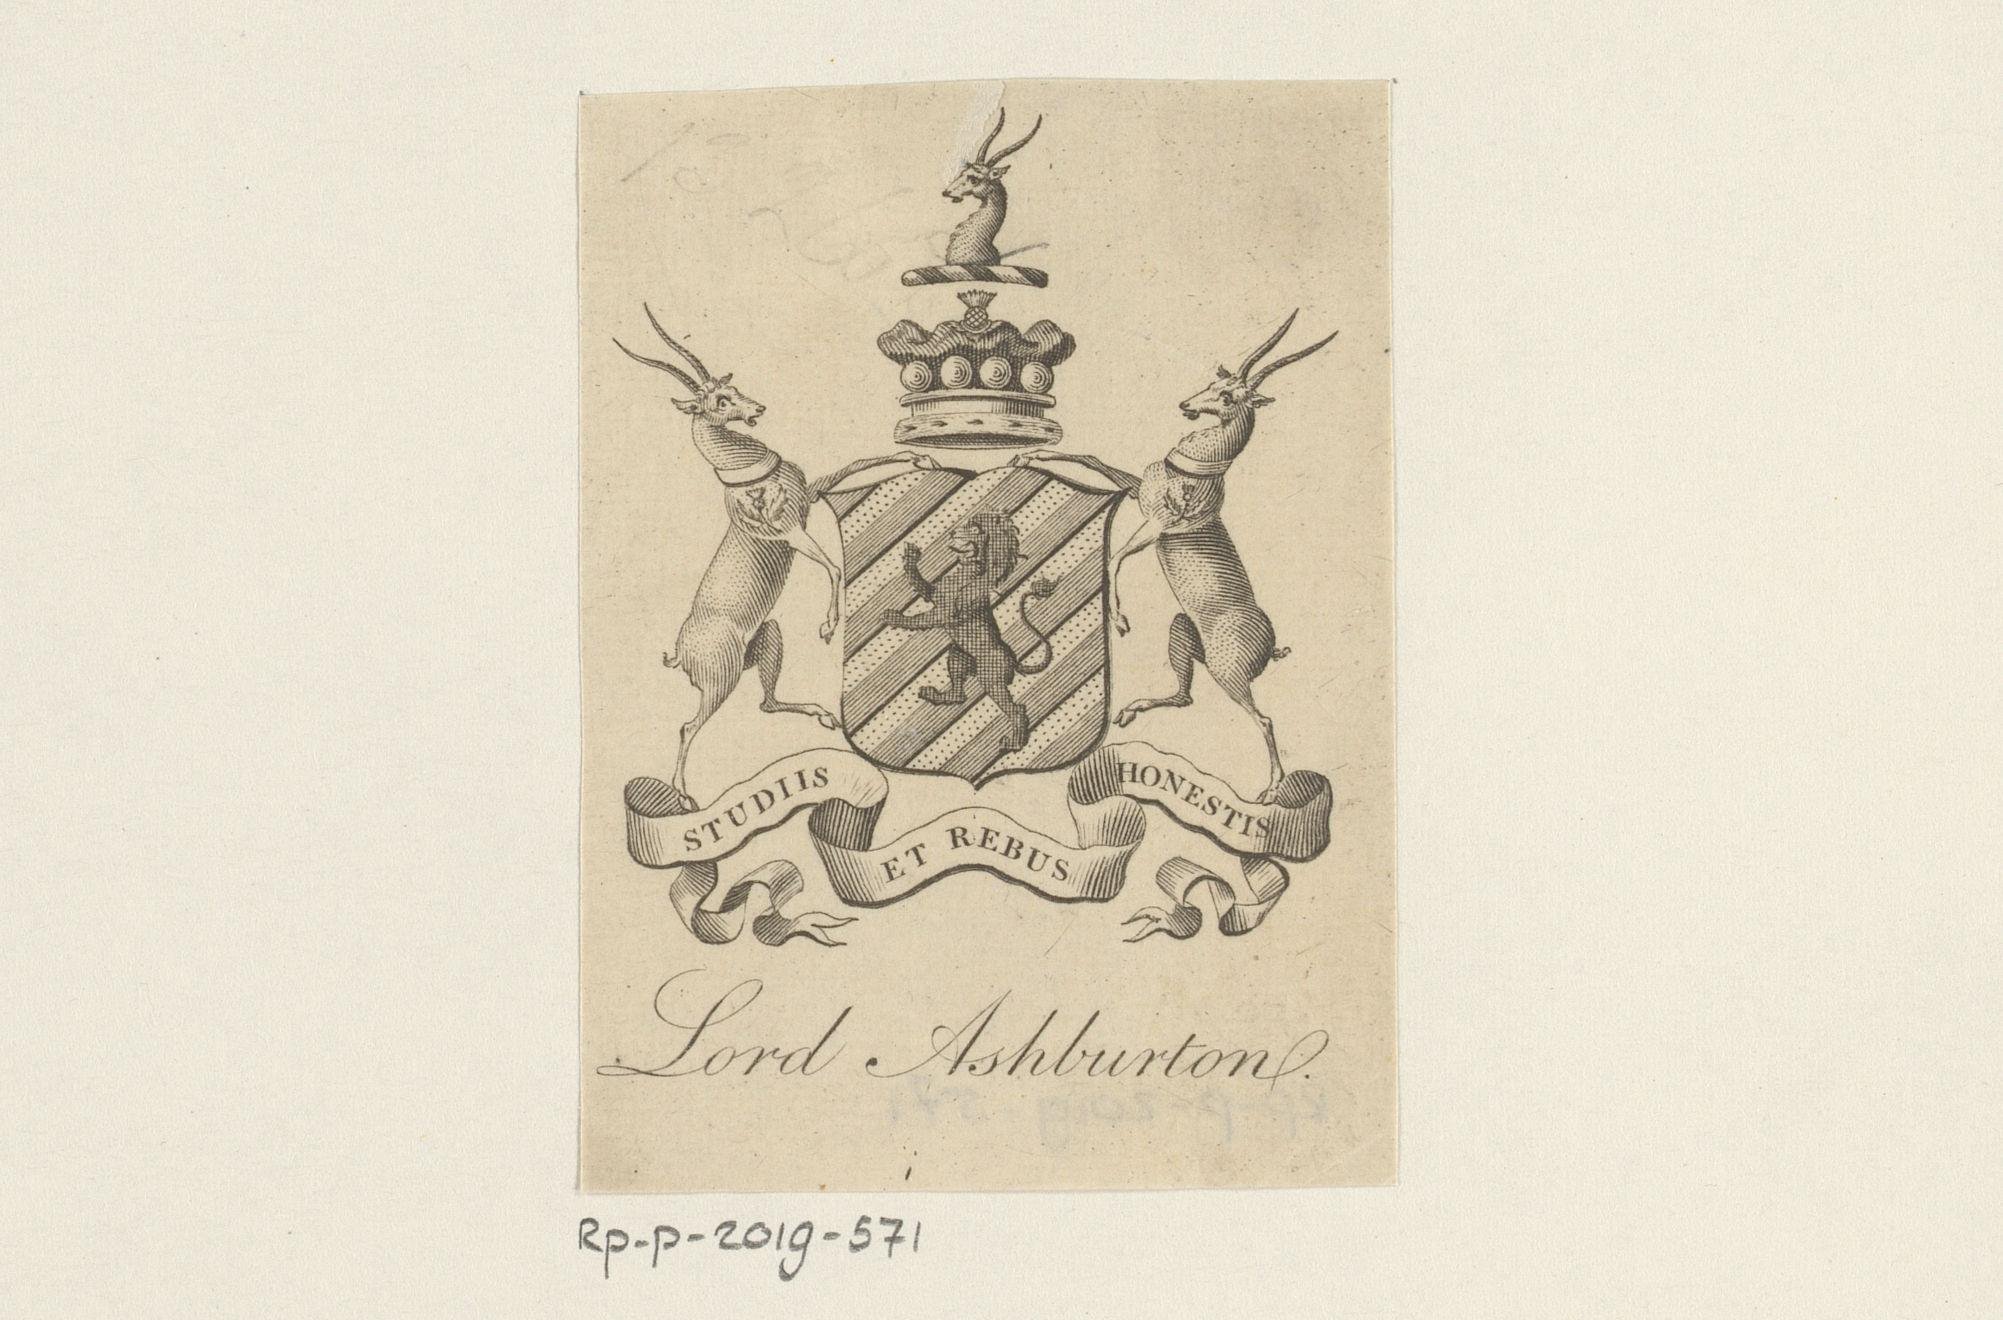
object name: bookplate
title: Studiis et rebus honestis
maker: Anonymous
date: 1700-1799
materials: paper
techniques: engraving, etching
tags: armorial bearing, heraldry